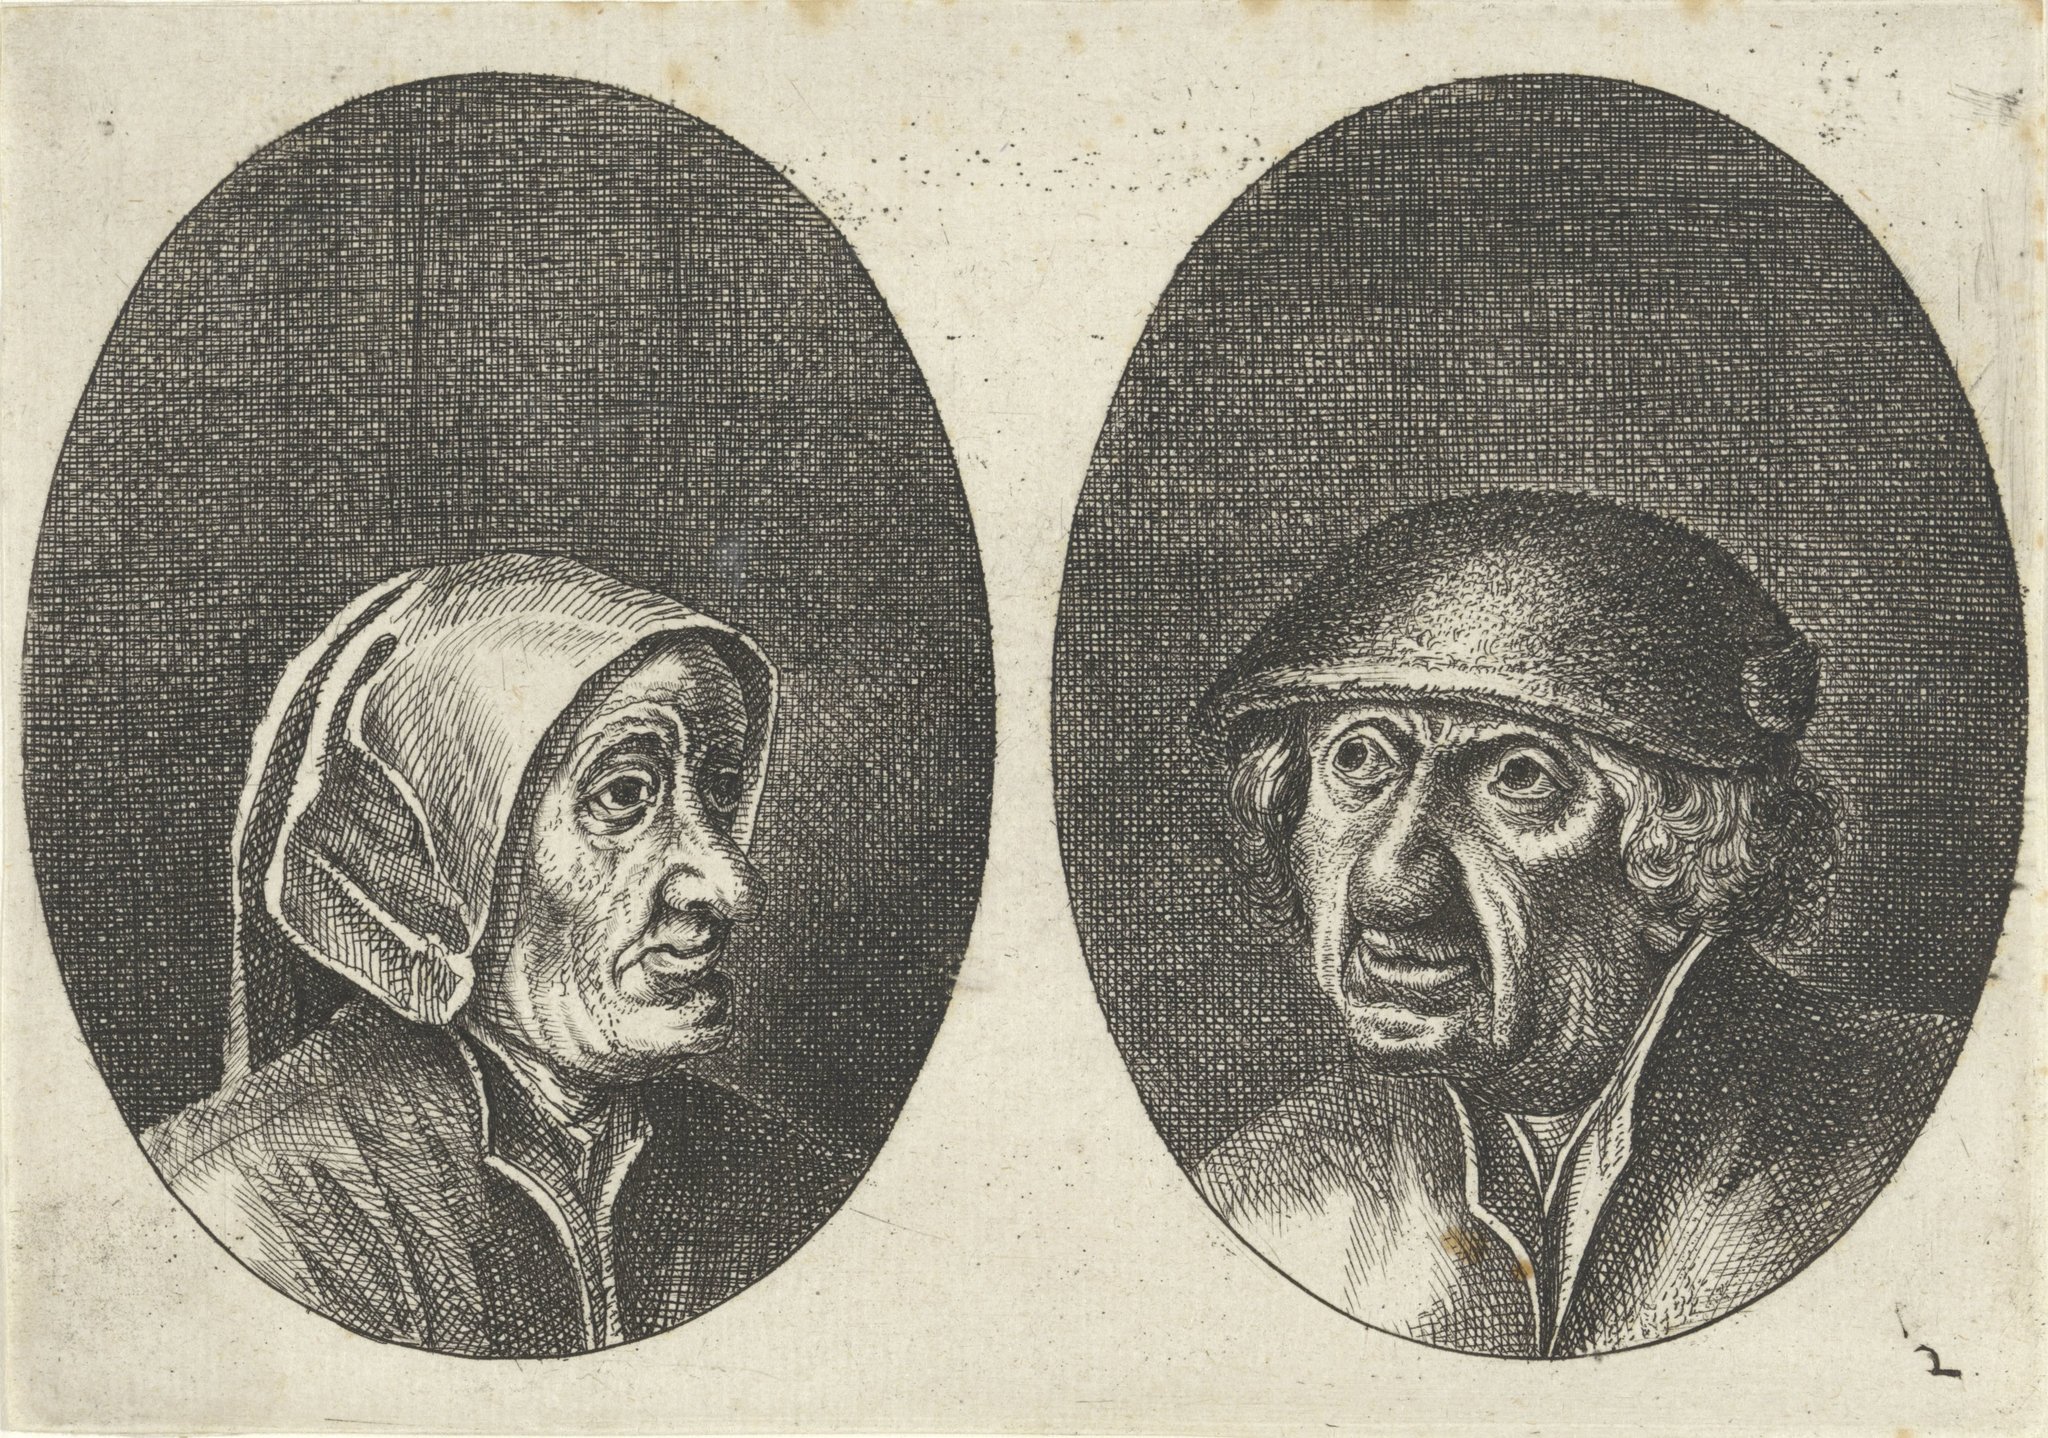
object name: print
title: Hoofden van boeren en boerinnen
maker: Anonymous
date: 1612-1702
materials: paper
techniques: engraving, etching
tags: head-gear, farmers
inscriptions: collector's mark: Lugt 240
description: Vergelijk nummer 6 uit de serie 'Boerenkoppen' uitgegeven door Claes Jansz Visscher (II) tussen 1601 en 1652.